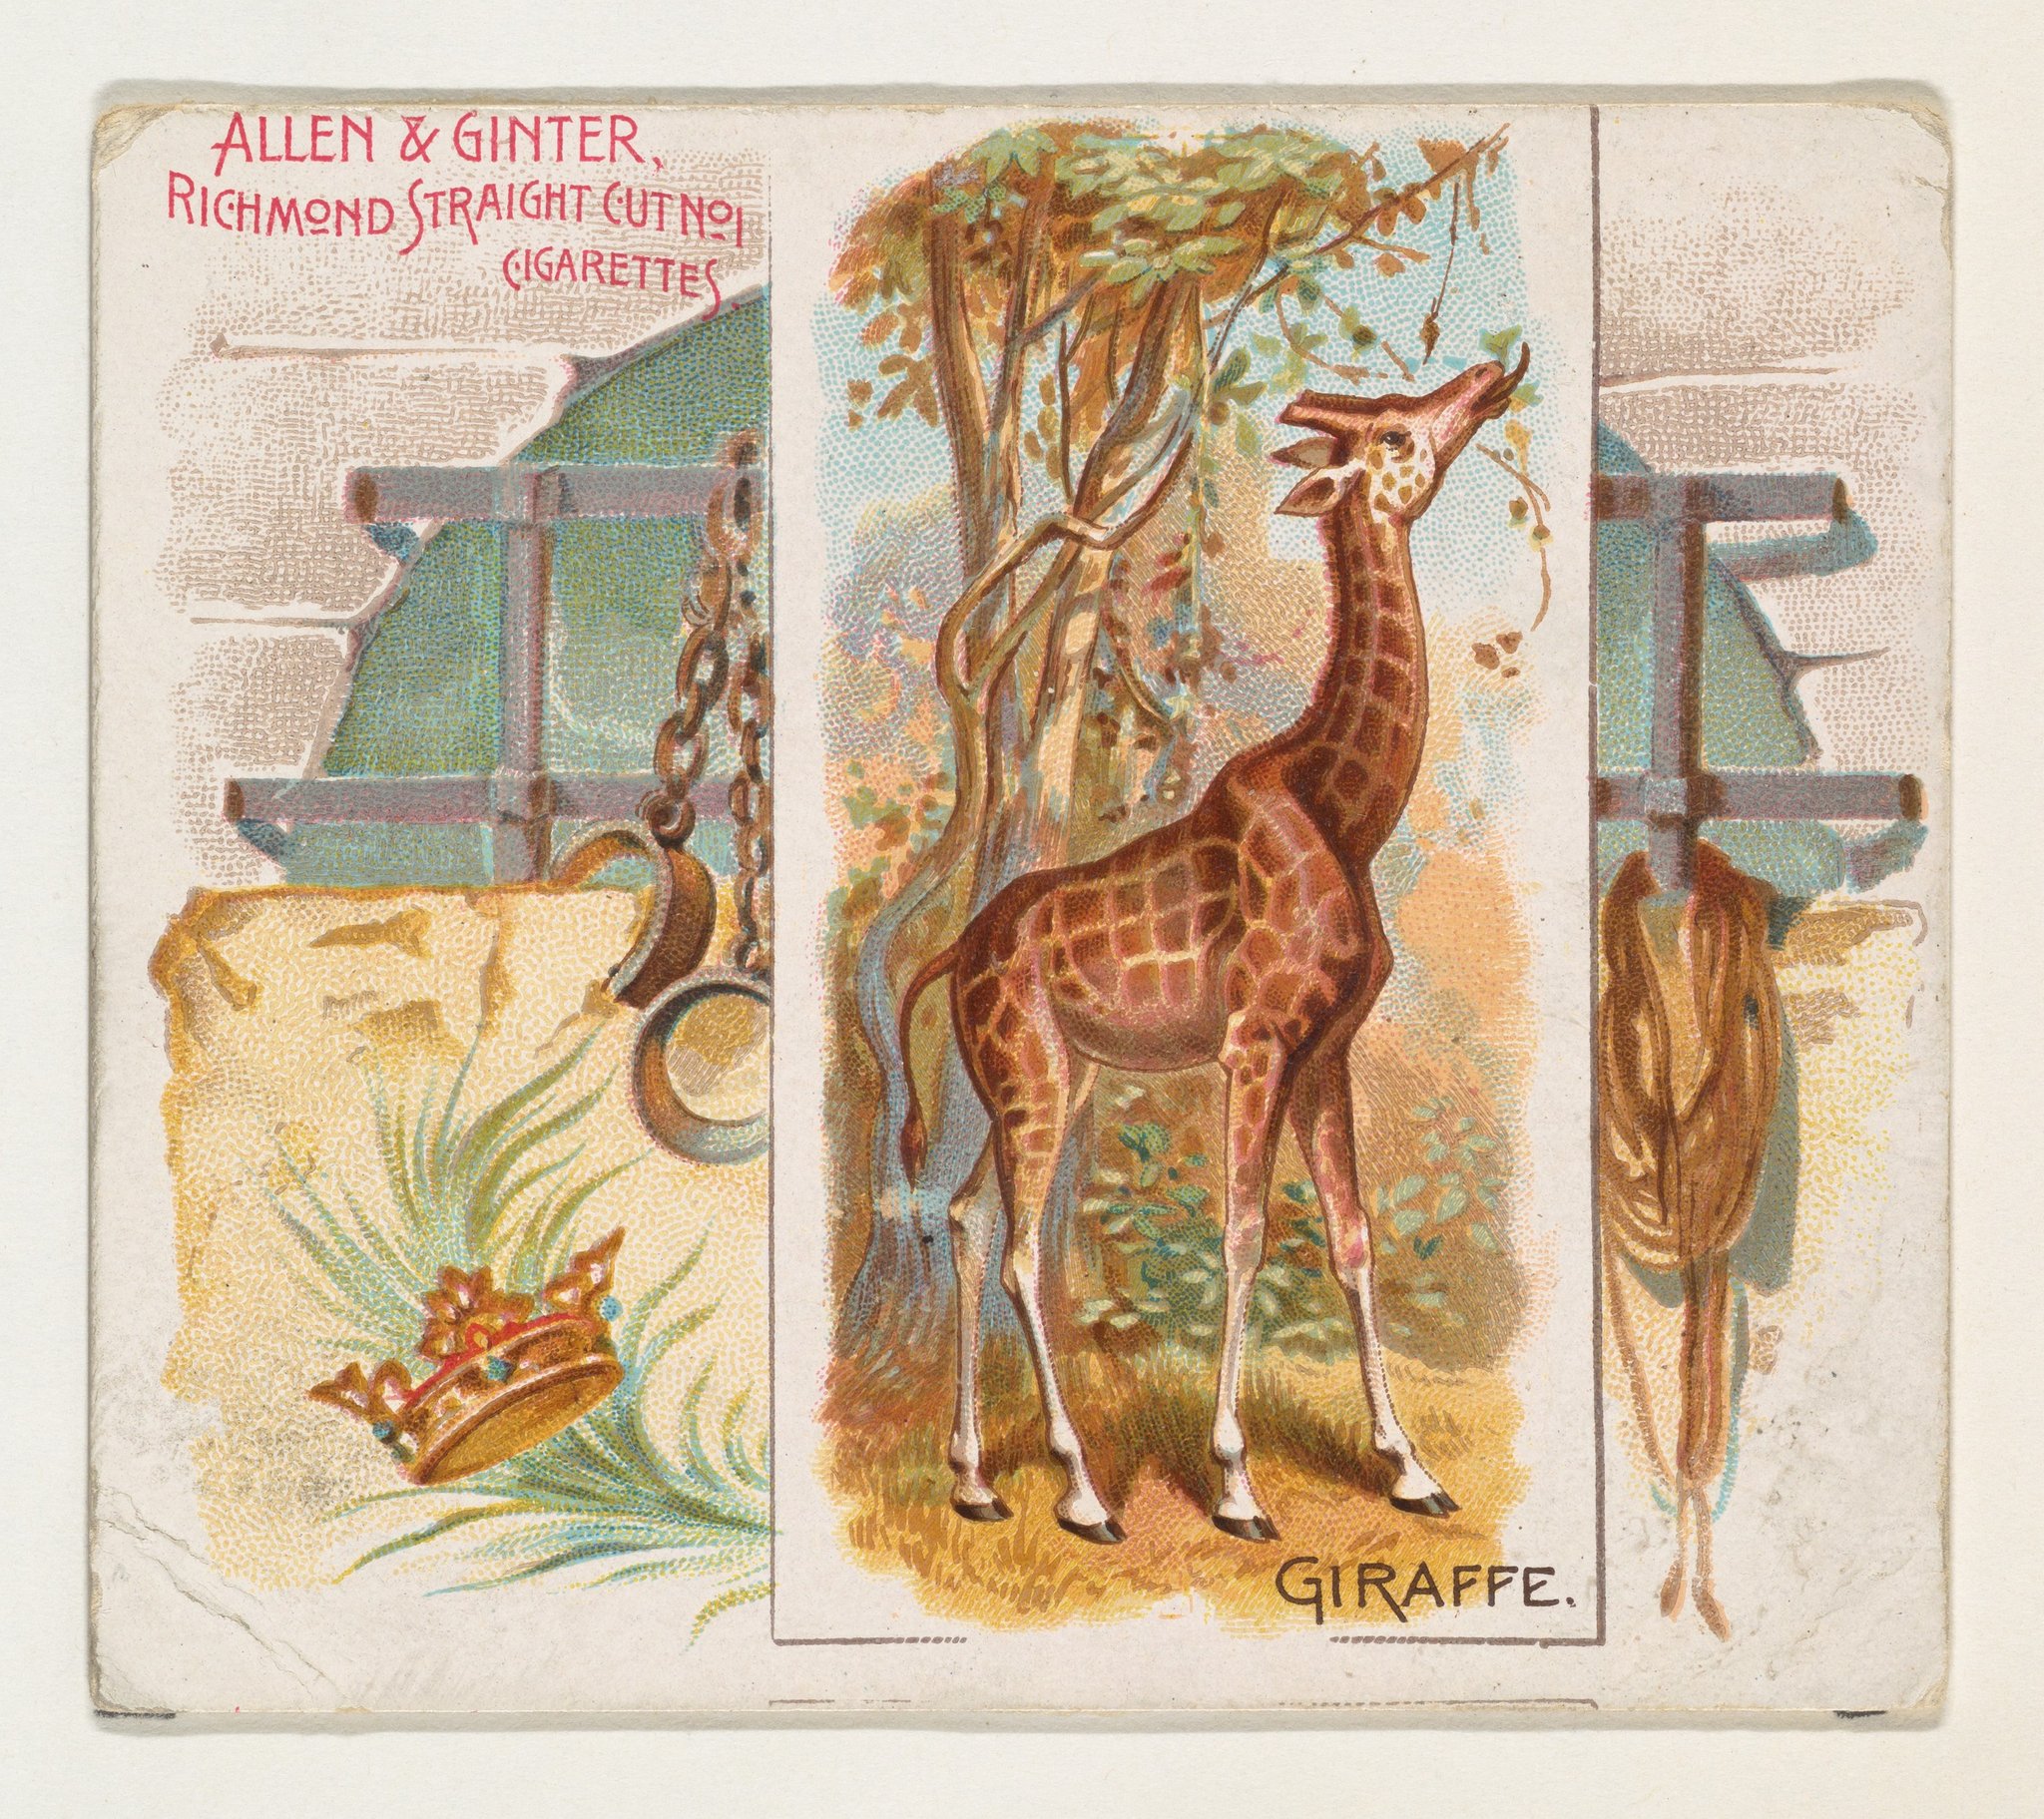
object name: print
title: Giraffe, from Quadrupeds series (N41) for Allen & Ginter Cigarettes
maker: allen & ginter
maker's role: publisher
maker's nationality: american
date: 1890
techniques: color lithograph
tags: giraffes